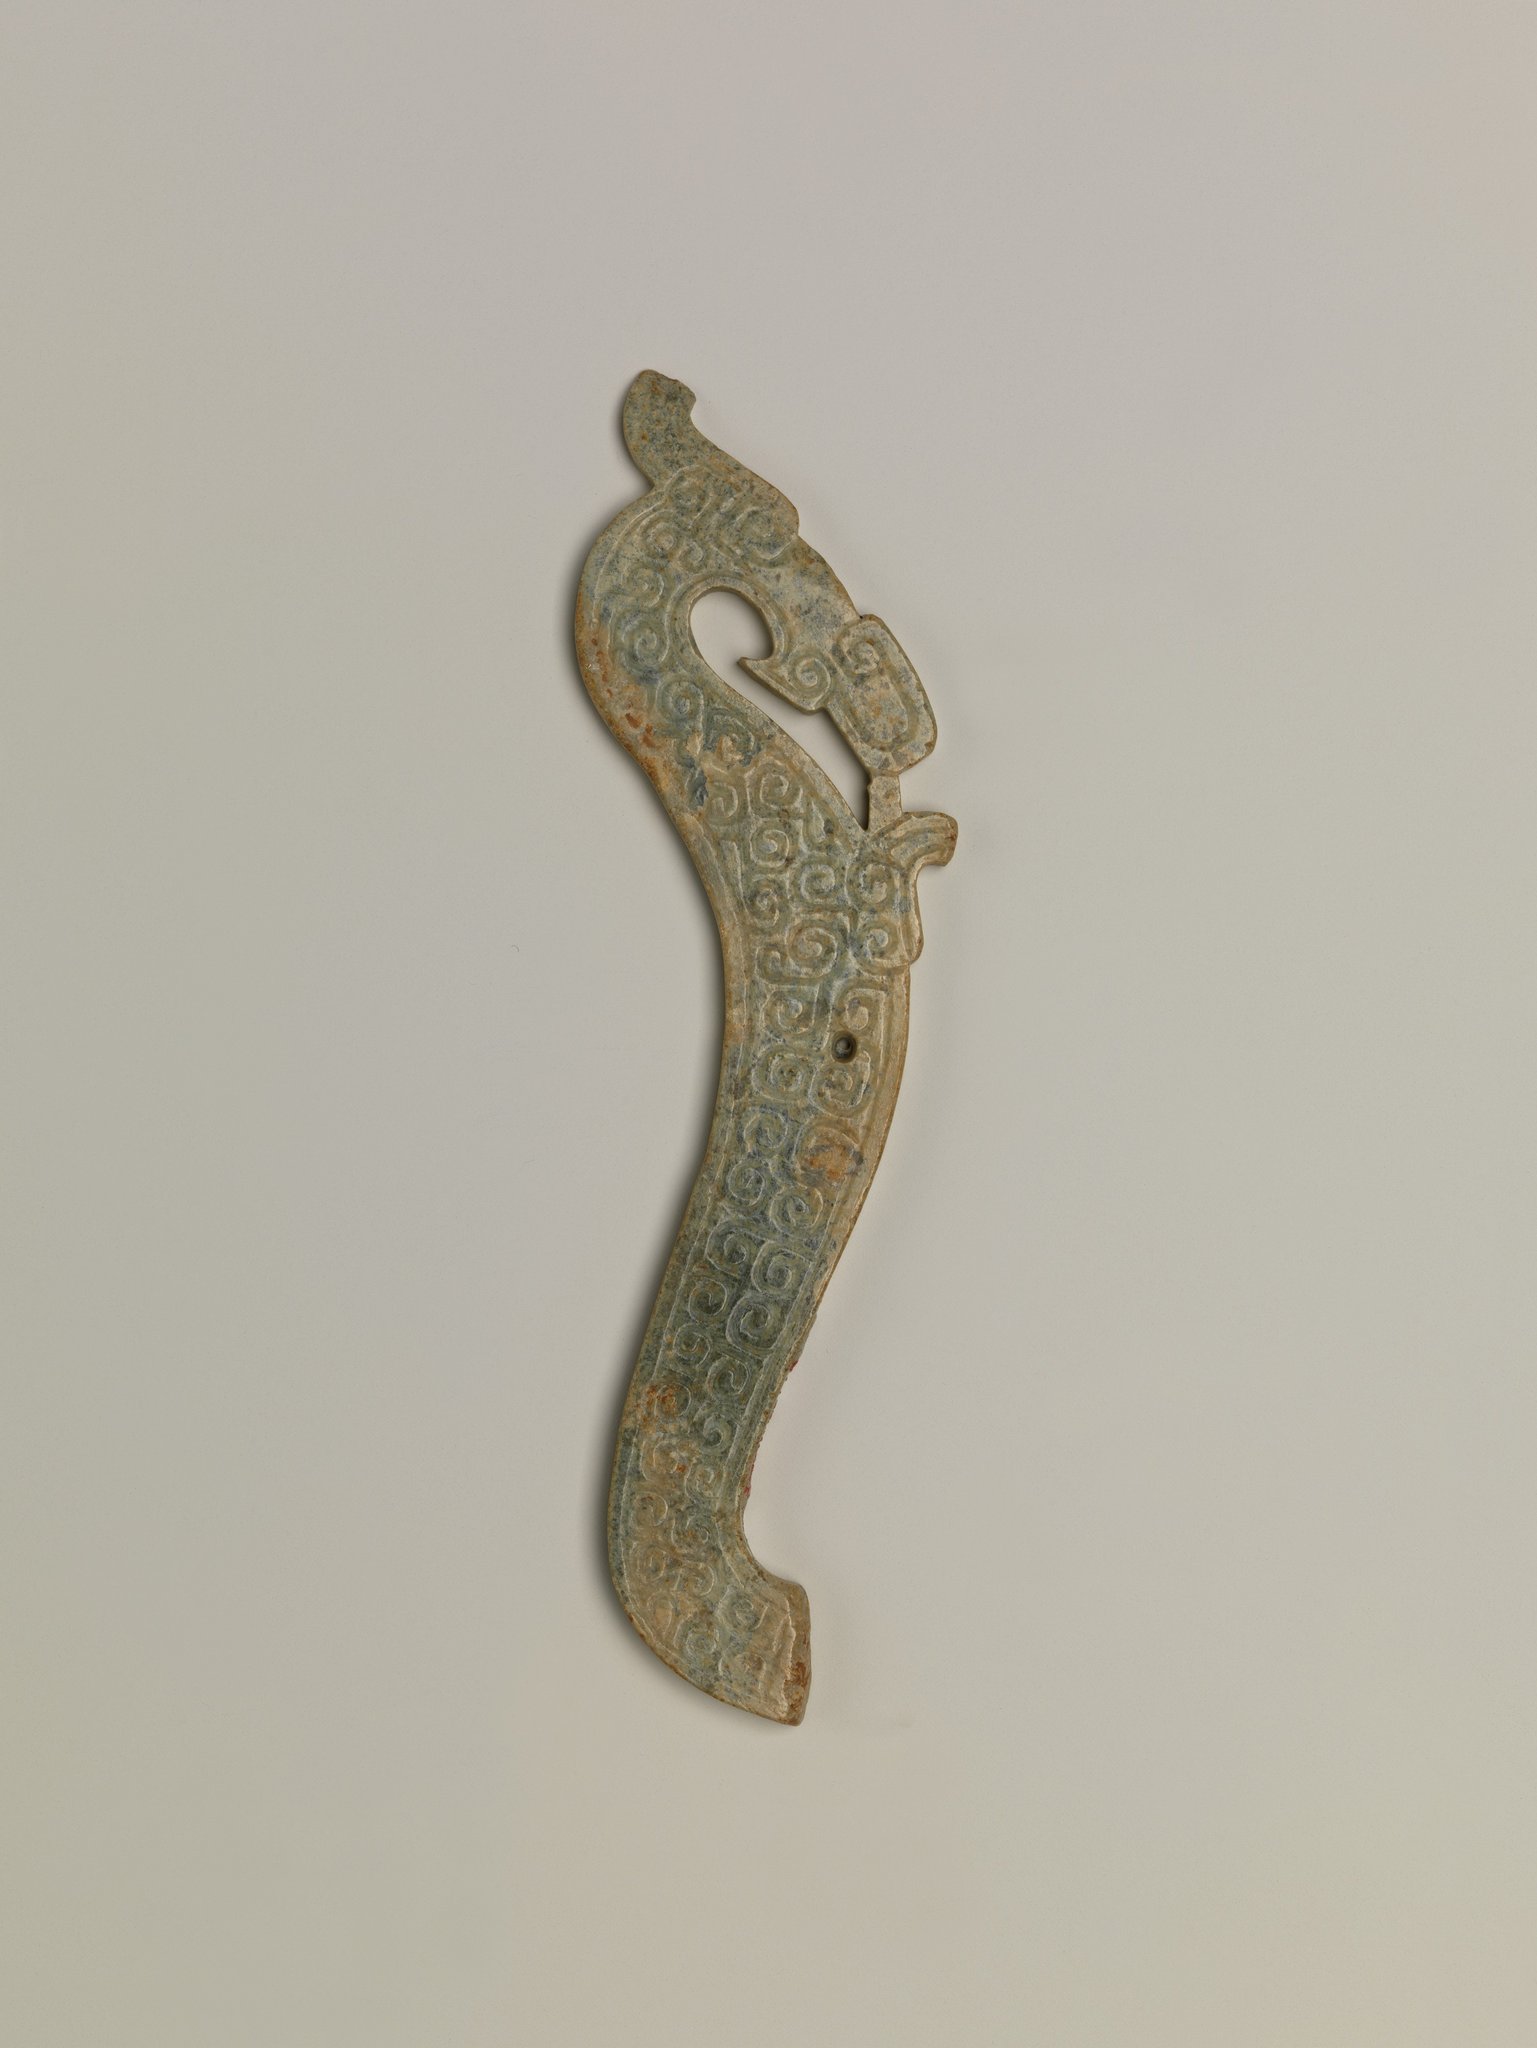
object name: pendant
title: Pendant in the shape of a crested dragon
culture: chinese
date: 500-401 BCE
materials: jade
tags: dragons